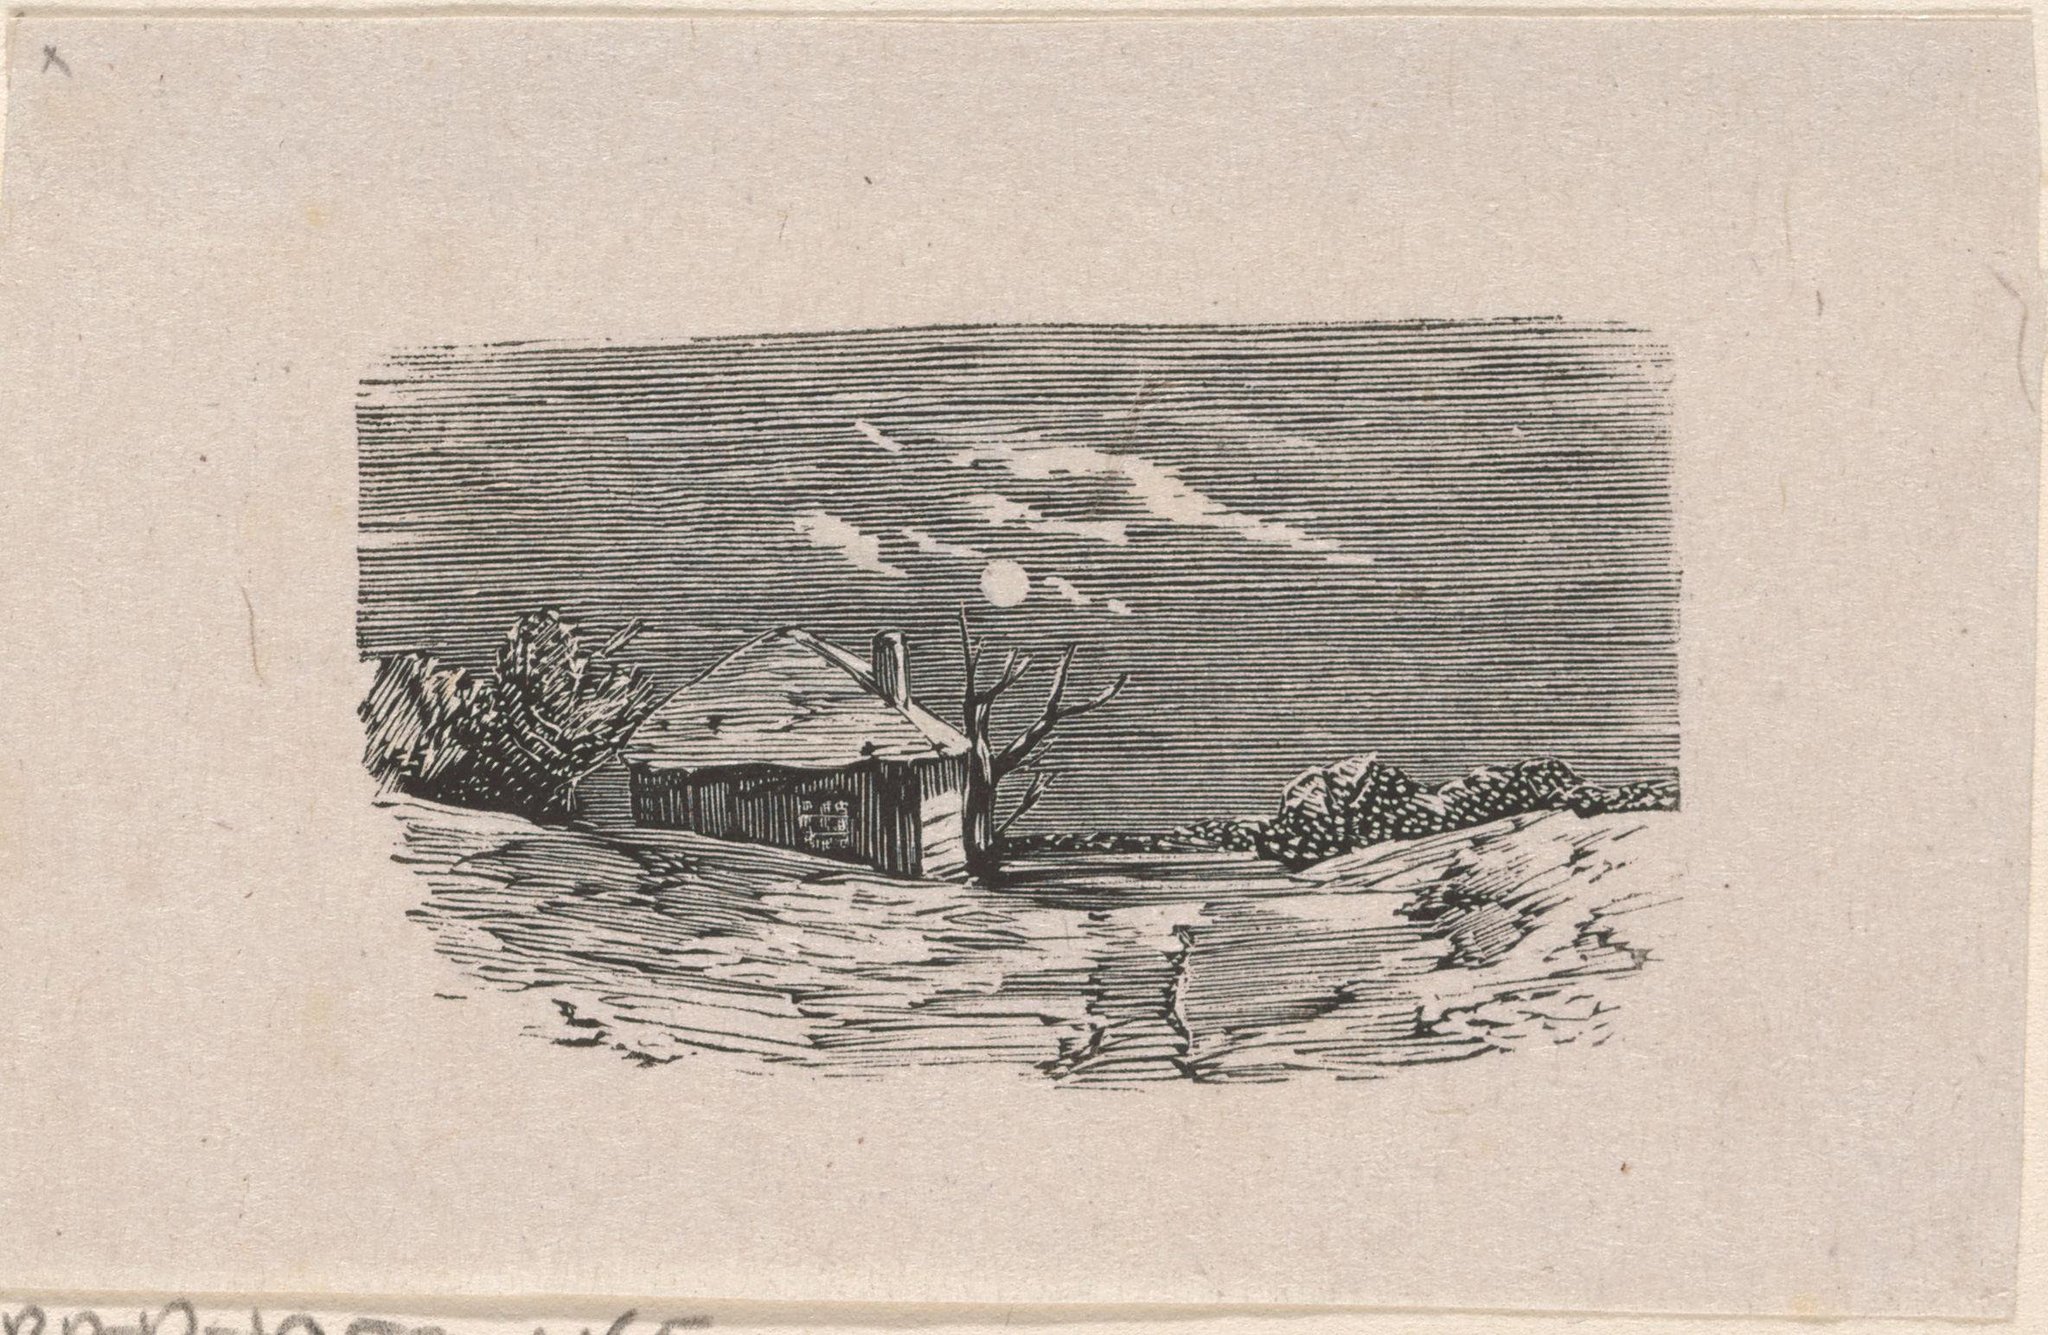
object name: print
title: Huis aan het water bij volle maan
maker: isaac weissenbruch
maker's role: print maker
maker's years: 1826-1912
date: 1836-1912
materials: paper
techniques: engraving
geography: netherlands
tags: full moon, the twelve months represented by scenes showing human activities, usually in a landscape; so-called 'labours of the months', farm or solitary house in landscape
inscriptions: collector's mark: Lugt 2228